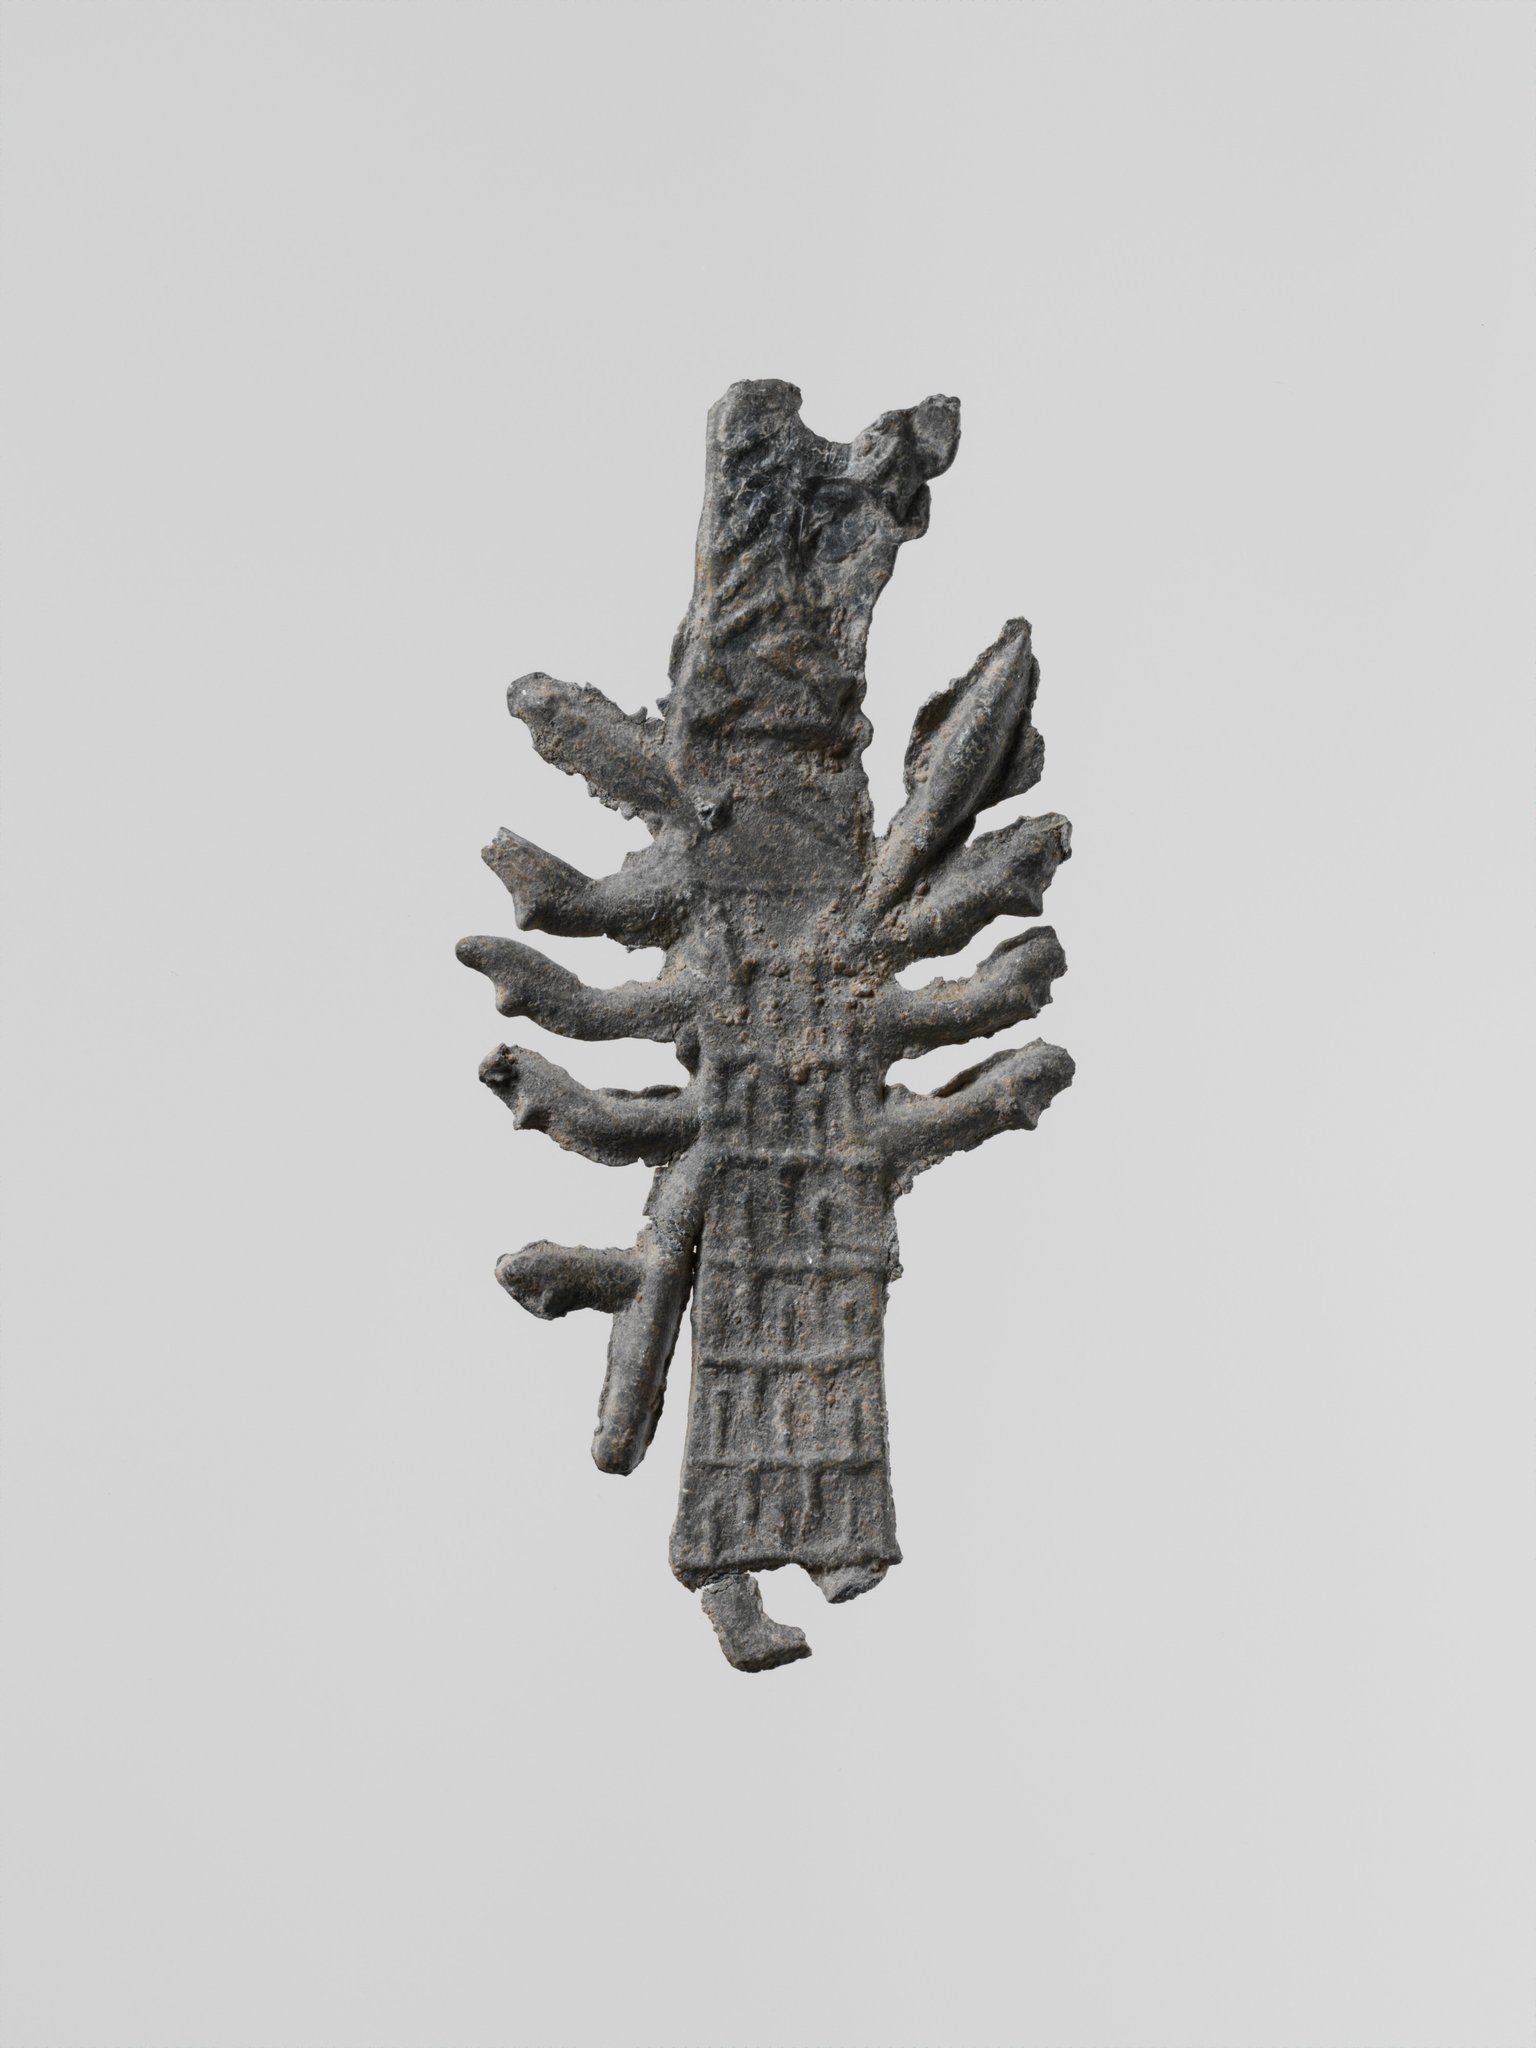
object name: statuette of athena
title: Lead figure of a goddess with a spear and aegis, probably Athena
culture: greek, laconian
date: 600-401 BCE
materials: lead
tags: spears,athena,goddess